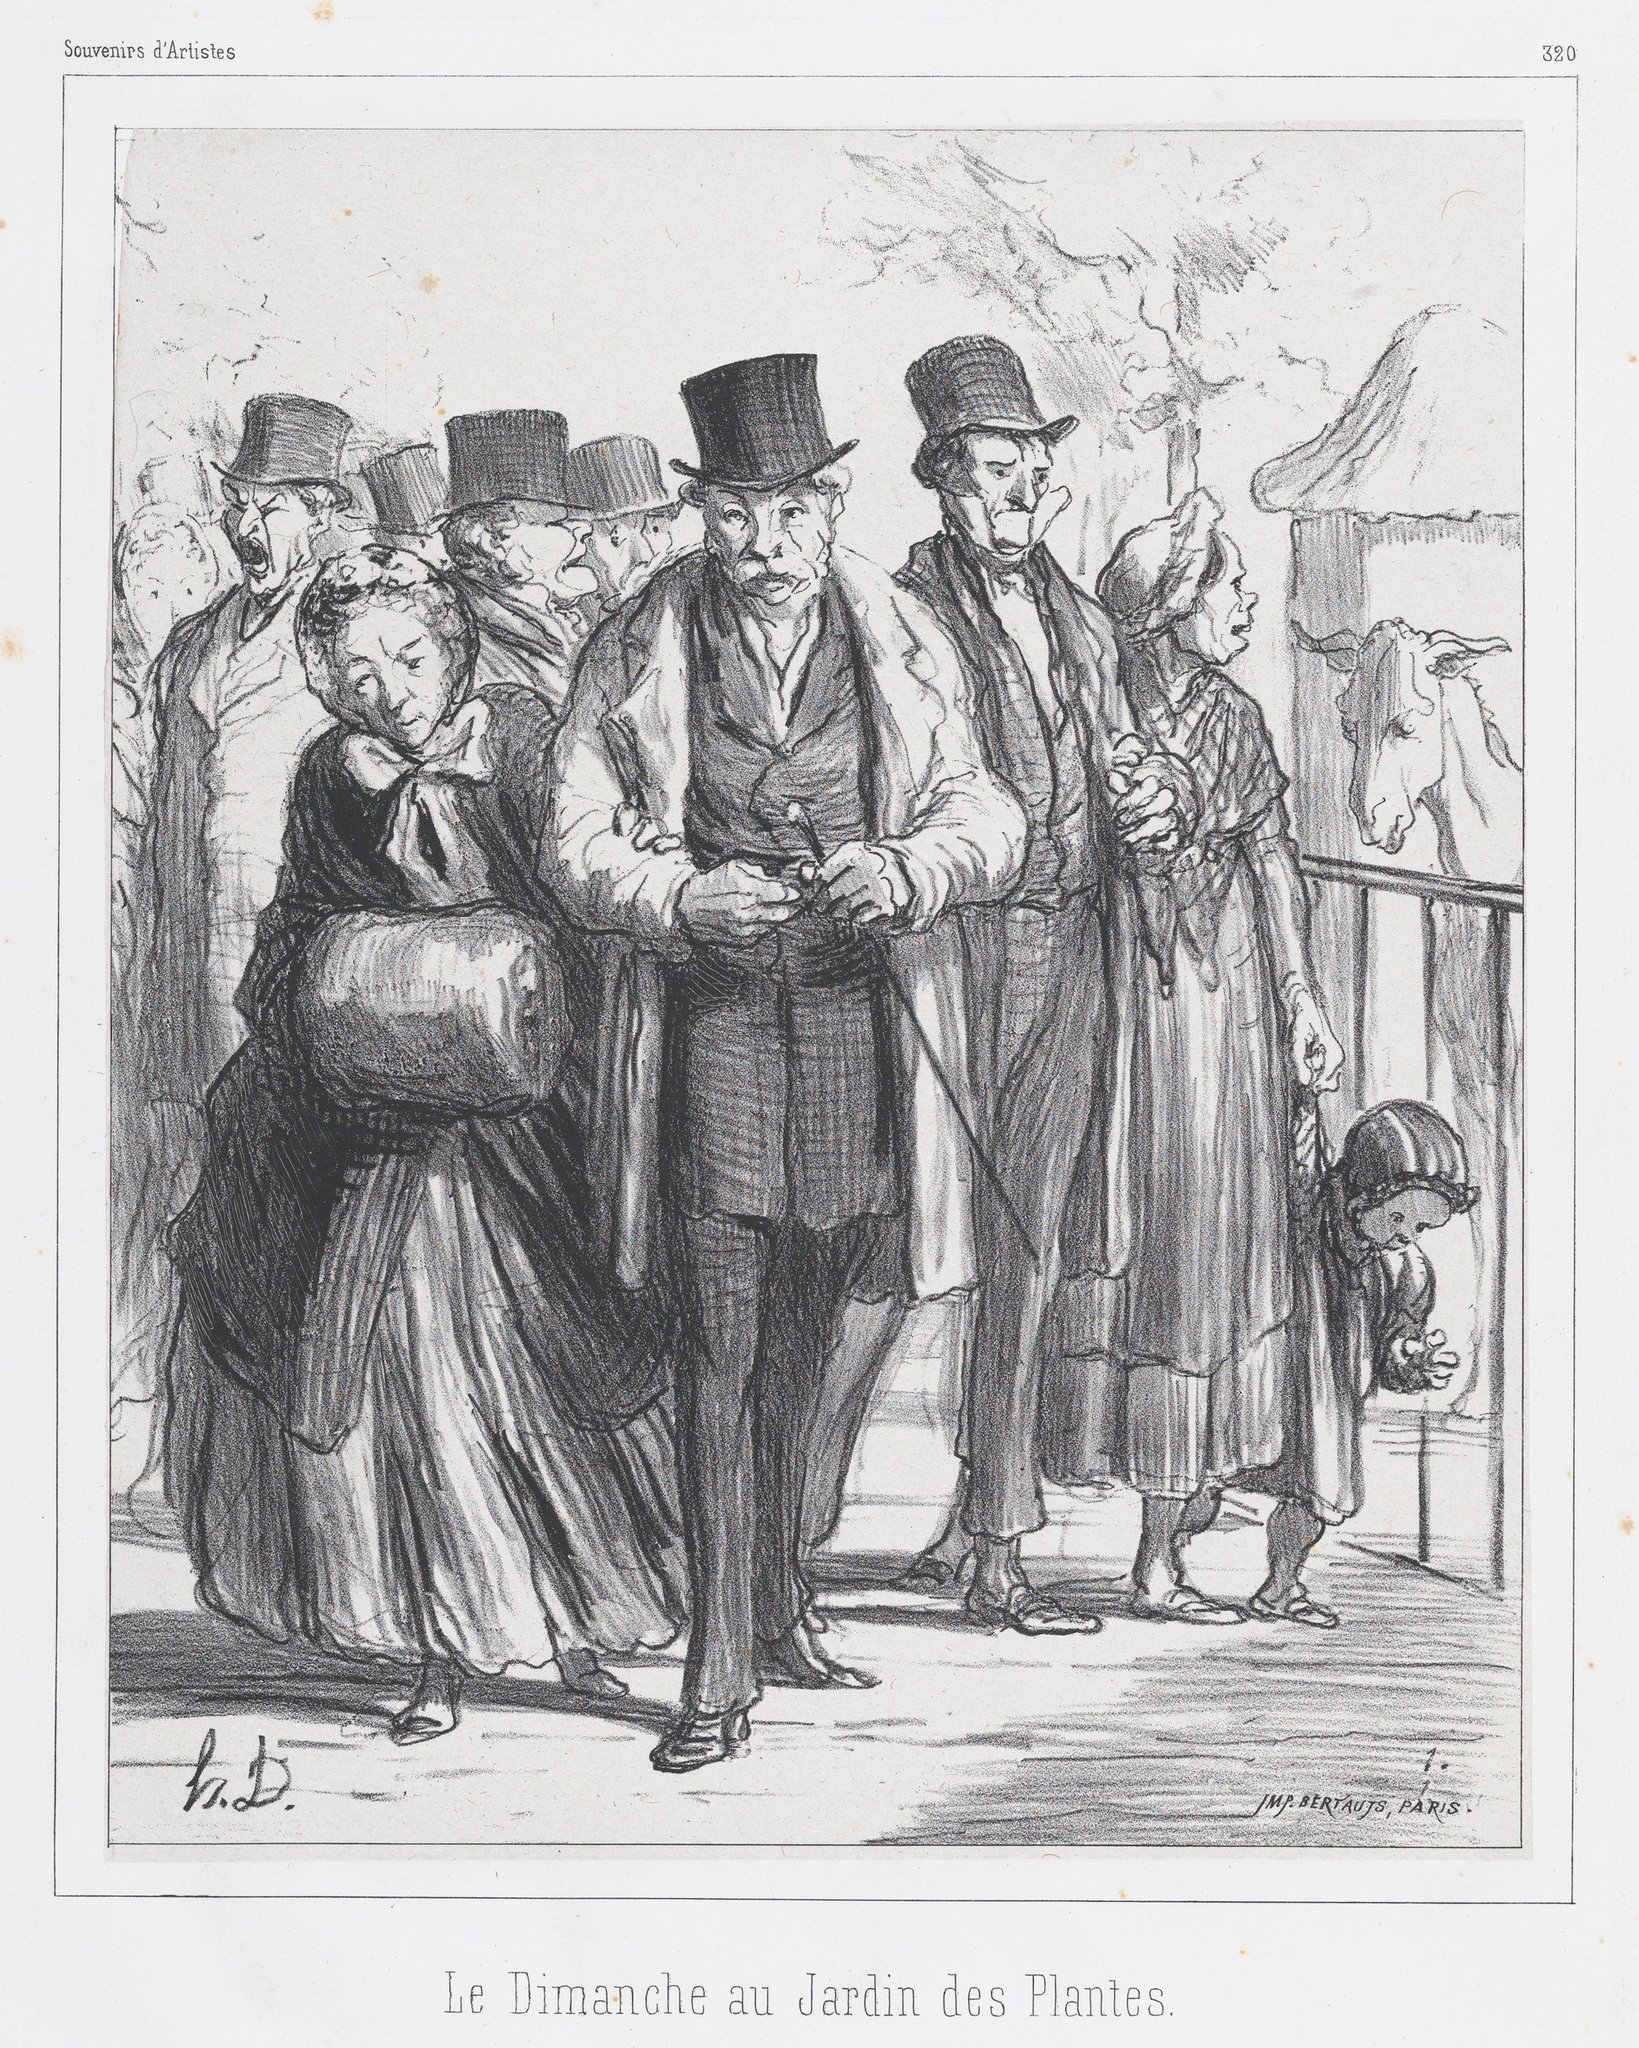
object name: print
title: A Sunday in the botanical gardens, published in Souvenirs d'Artistes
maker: honoré daumier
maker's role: artist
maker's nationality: french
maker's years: 1808-1879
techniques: lithograph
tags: animals,girls,men,women